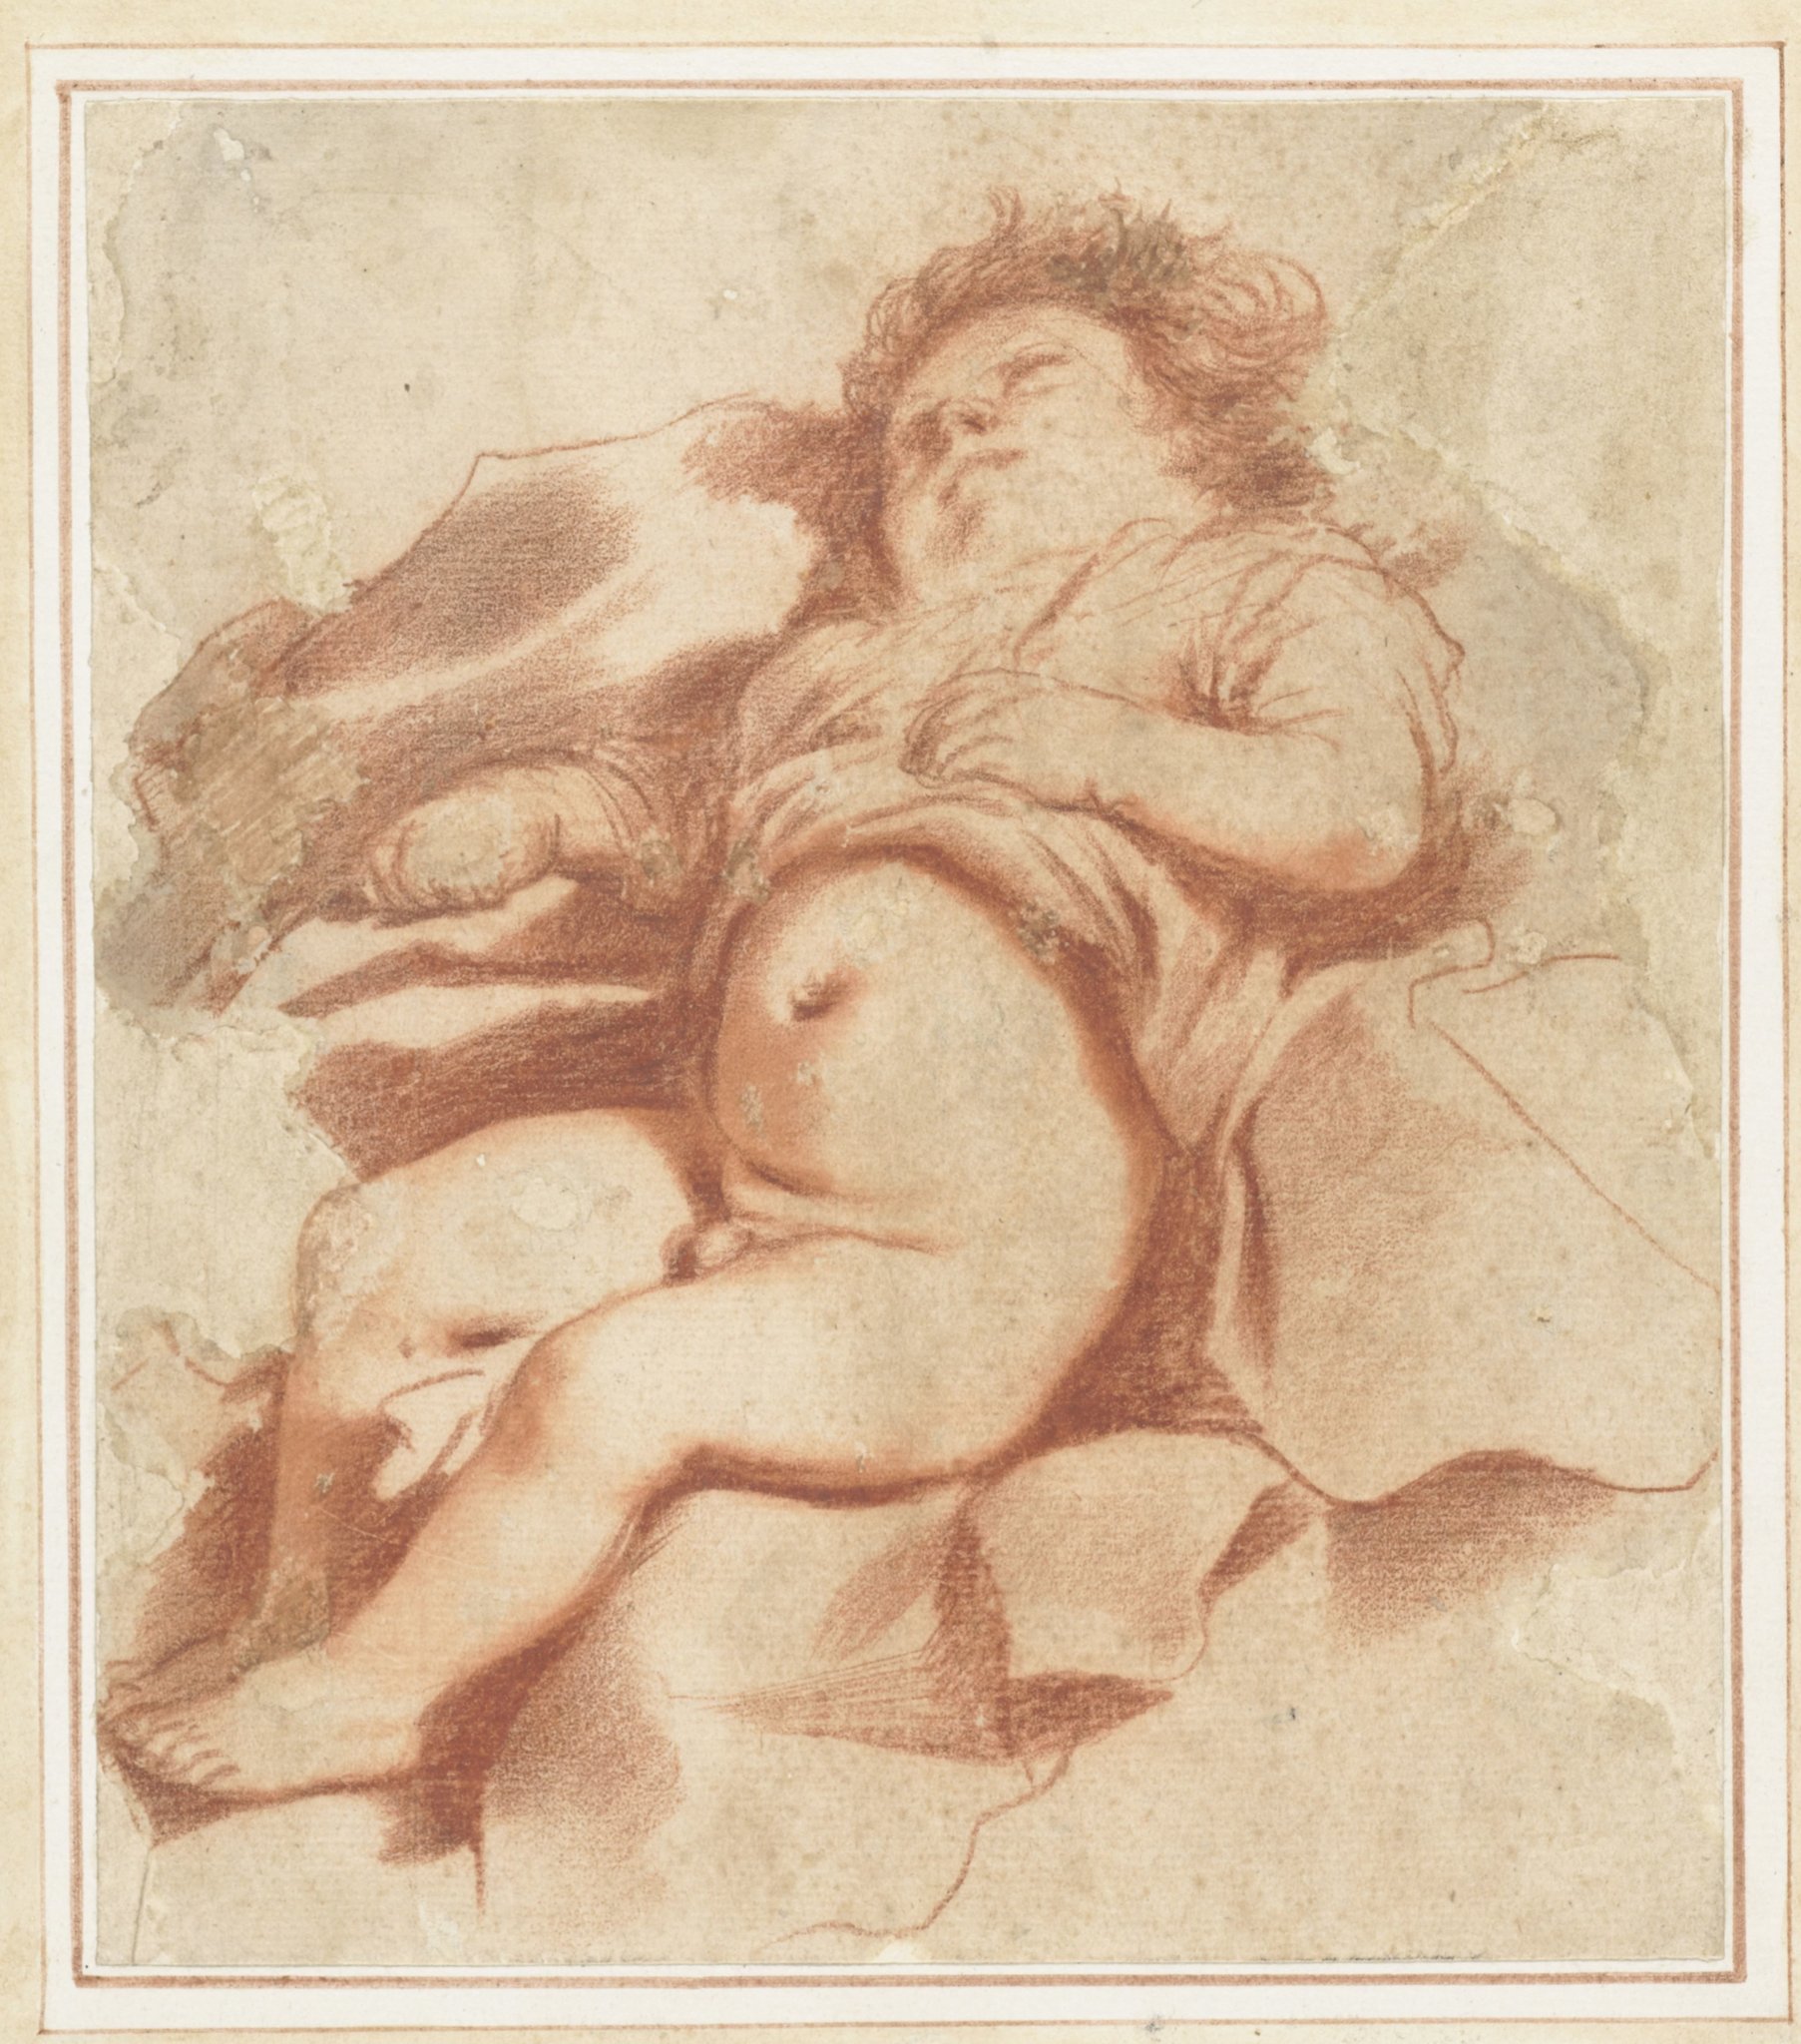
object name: drawing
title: Studie van een slapend kind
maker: g.jo.franc da cento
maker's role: draughtsman, painter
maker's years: 1591-1666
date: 1619-1624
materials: chalk, paper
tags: male infant, sleeping; unconsciousness